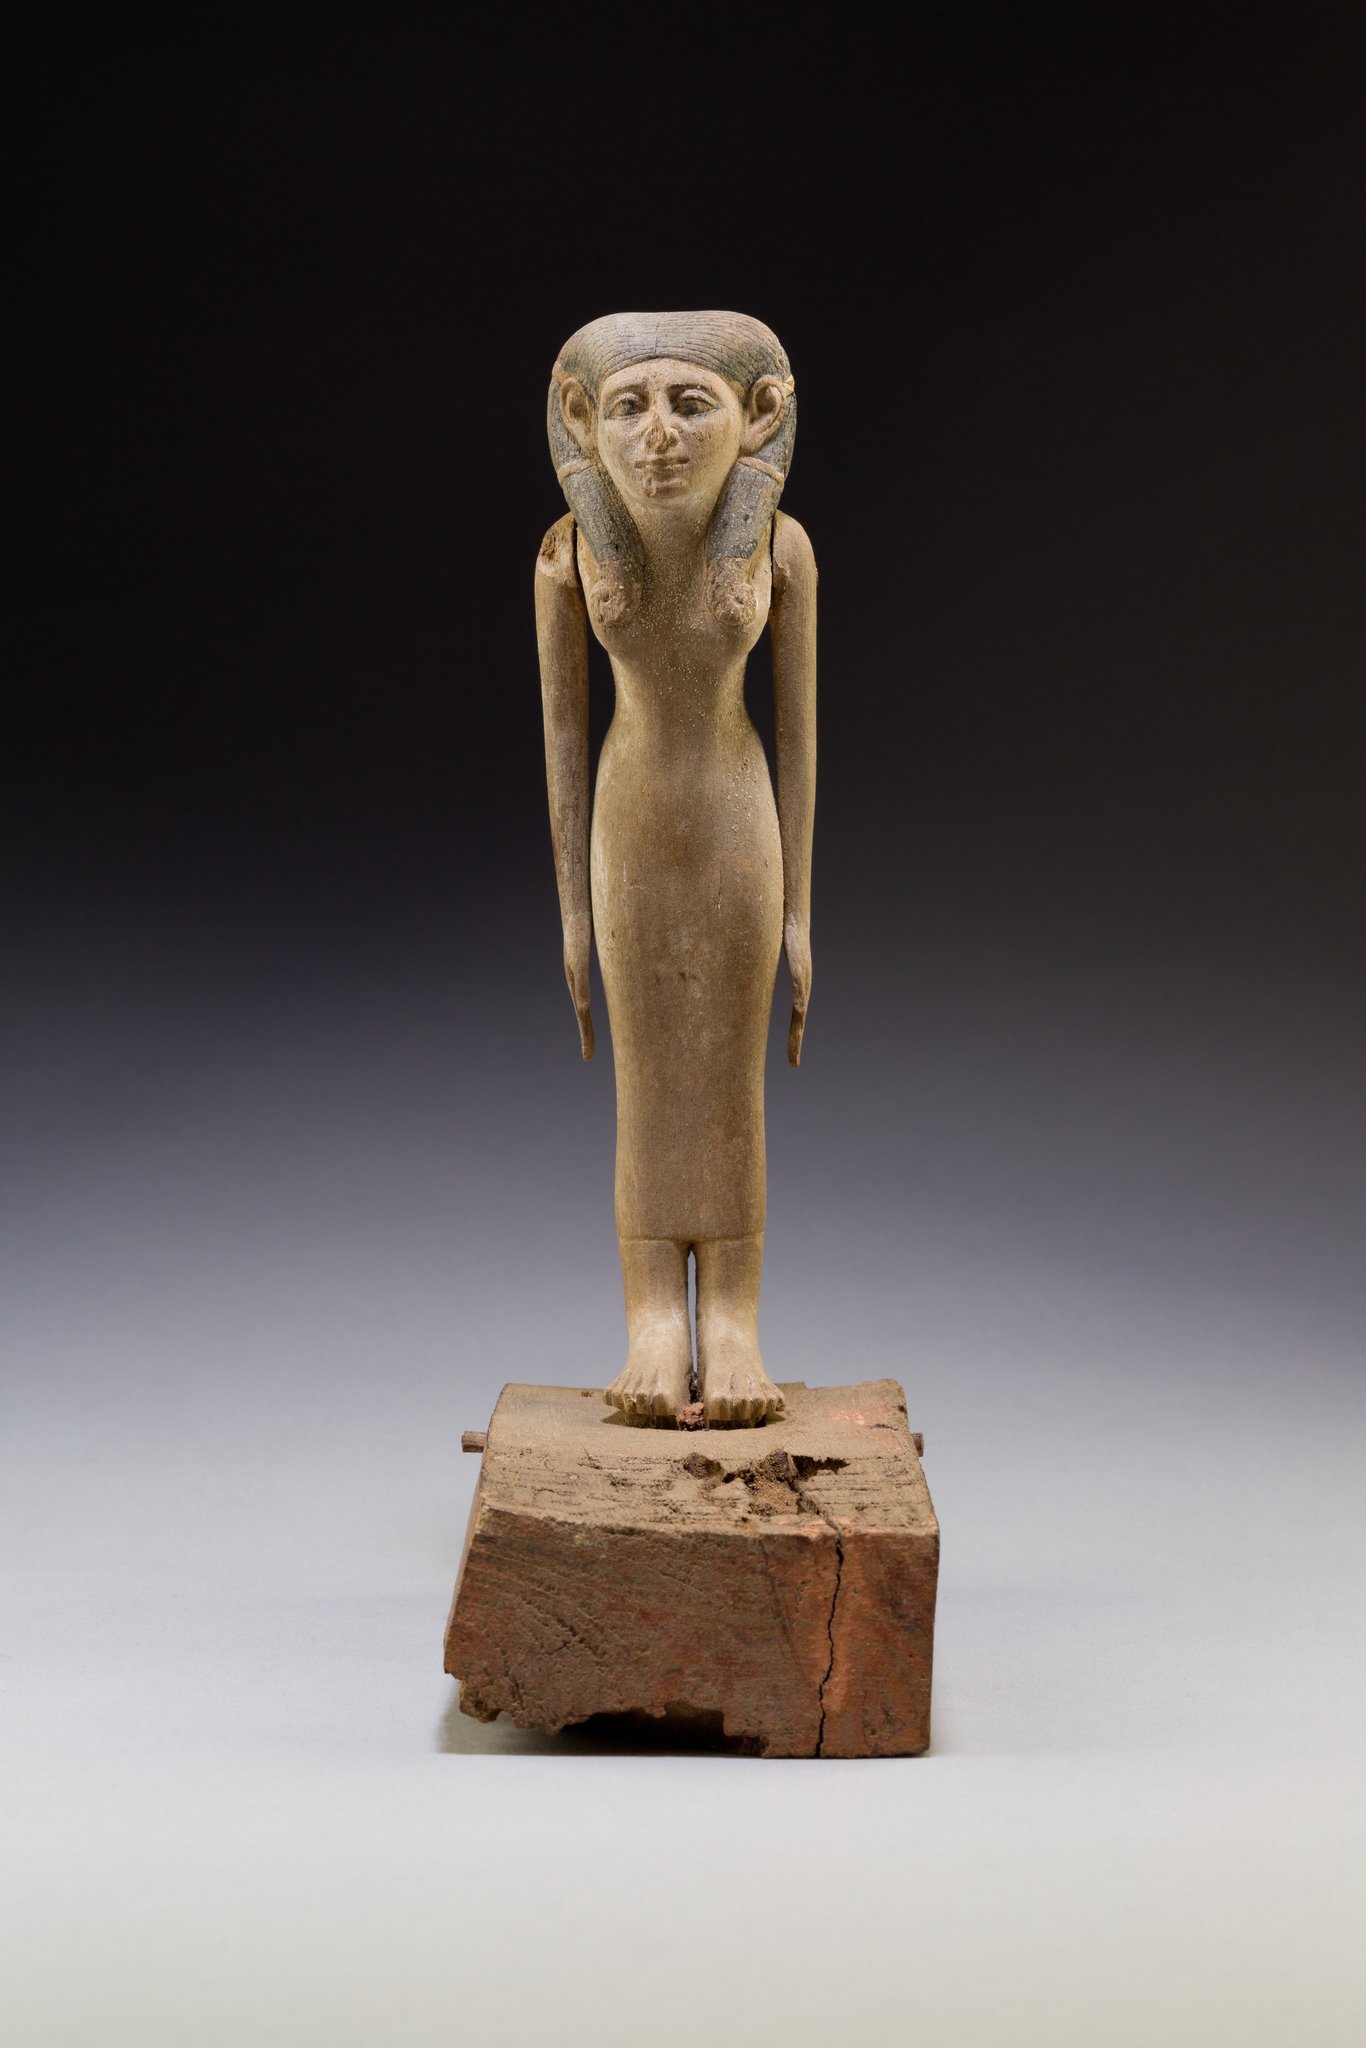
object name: statuette, lady kemtet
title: Statuette of Lady Kemtet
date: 1900-1802 BCE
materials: wood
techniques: painting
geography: egypt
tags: women